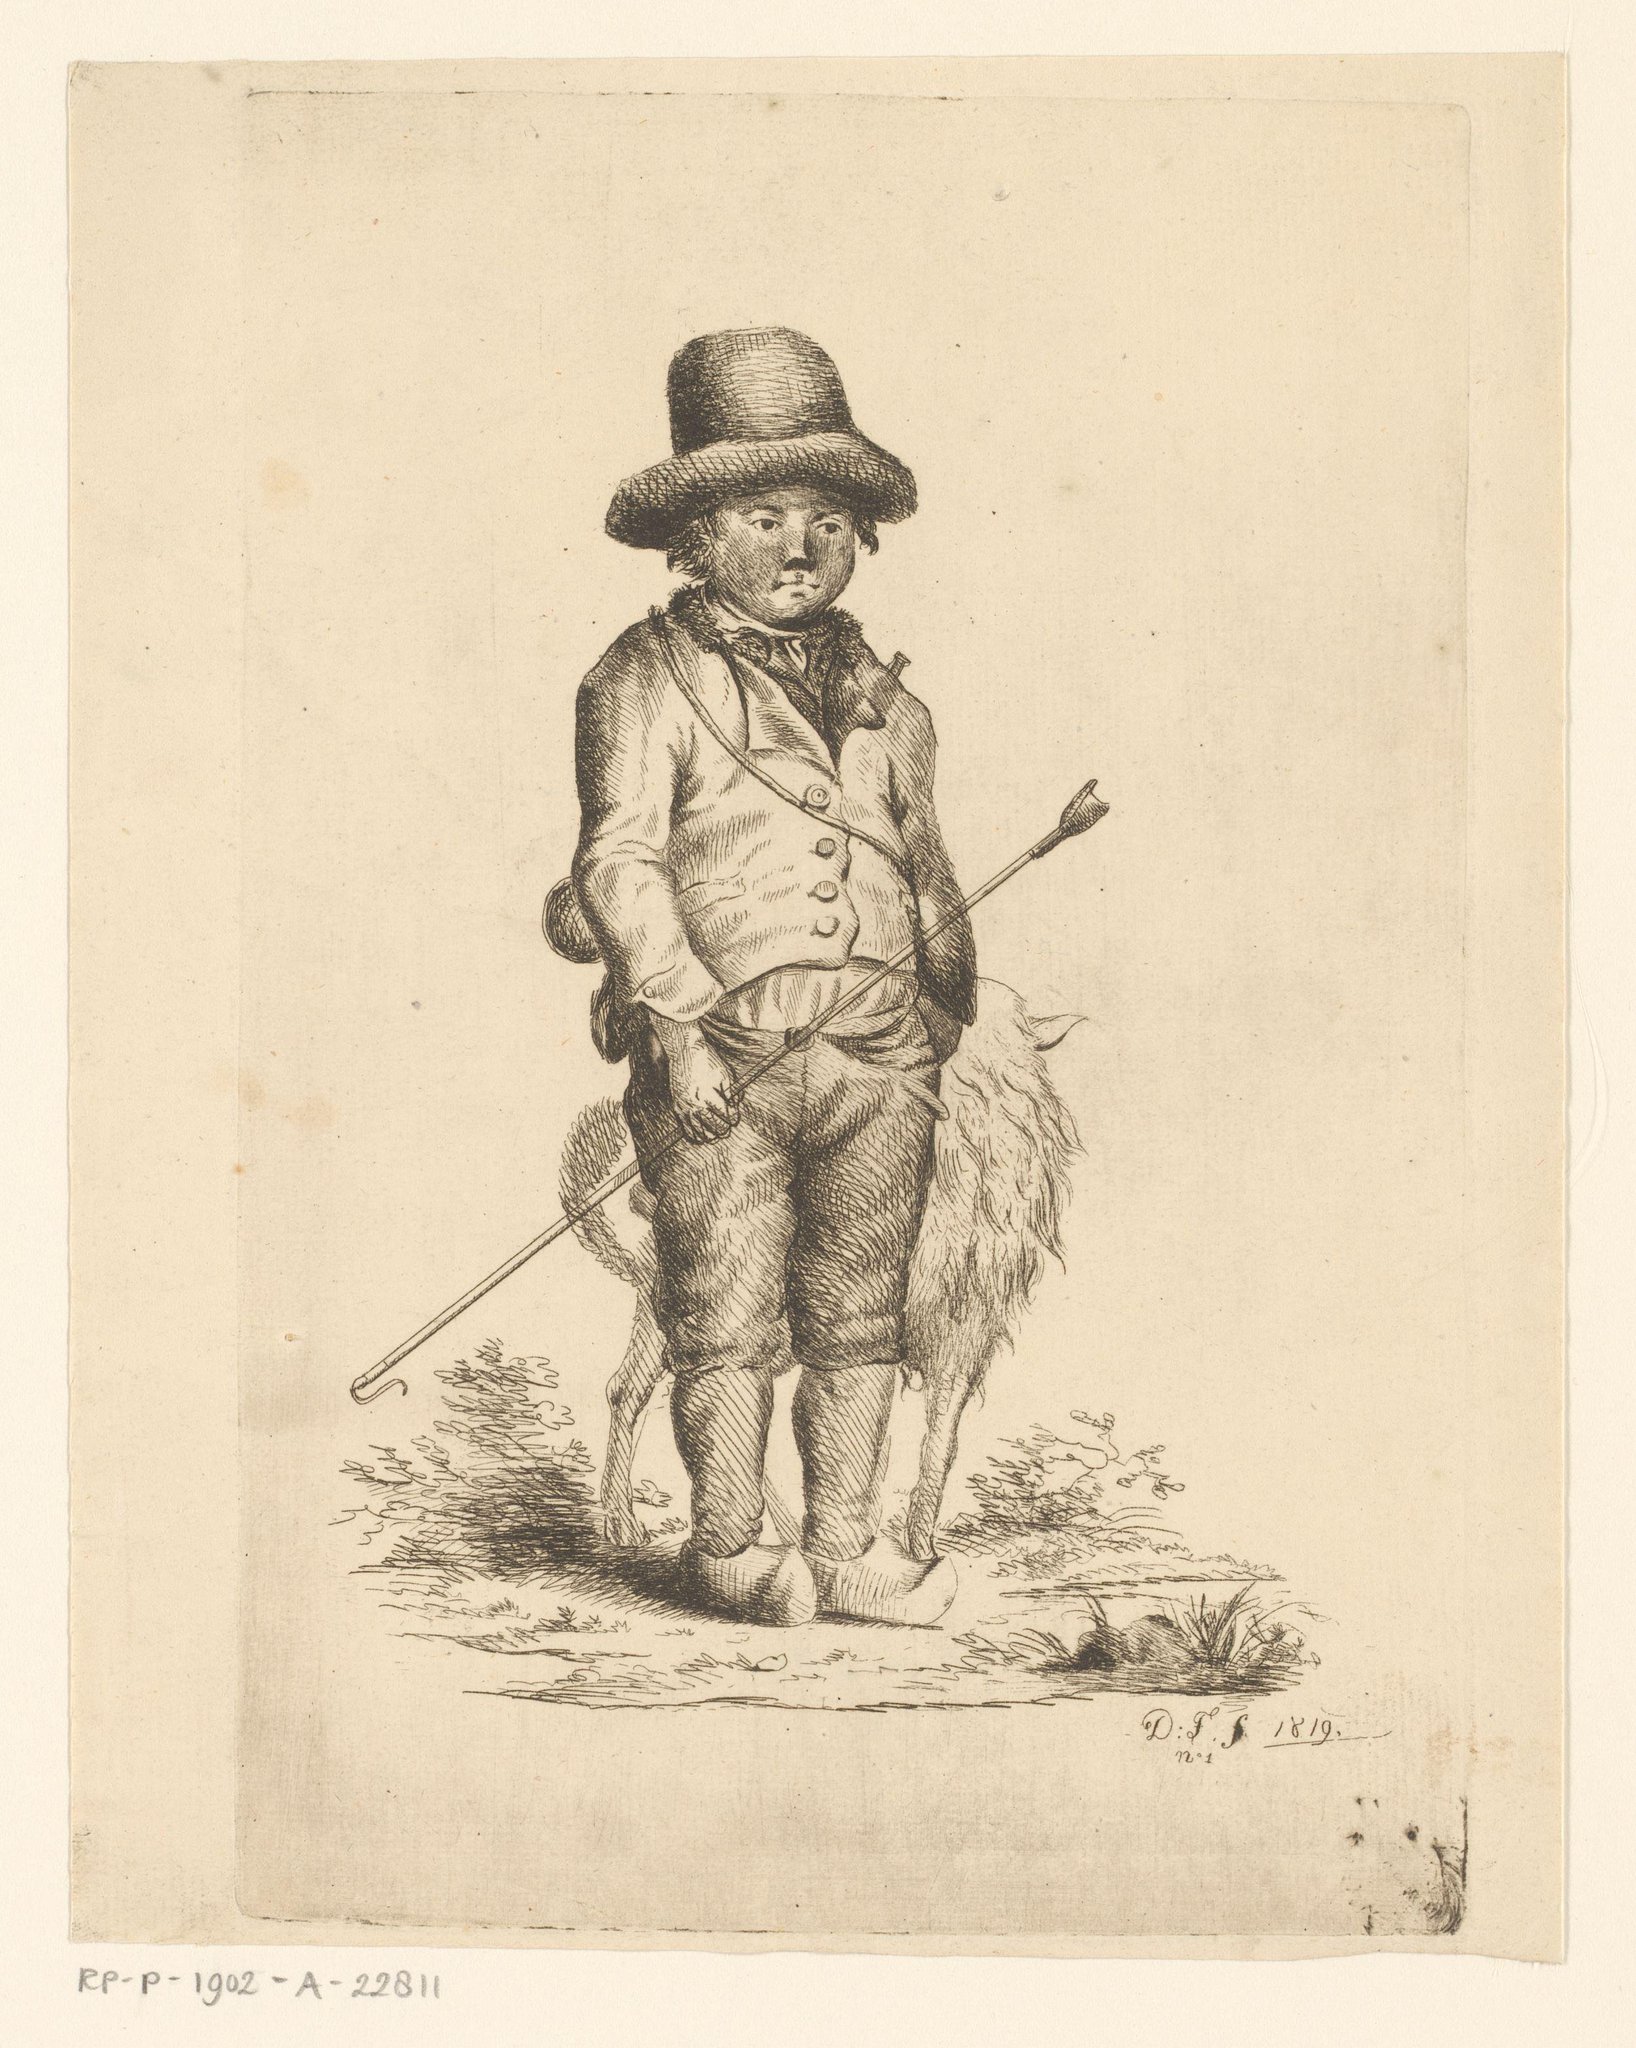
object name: print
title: Jonge herder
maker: monogrammist df (graveur)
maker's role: print maker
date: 1819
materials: paper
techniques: etching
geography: netherlands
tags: herding, herdsman, herdswoman, shepherd, shepherdess, cowherd, etc., sheep, dog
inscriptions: collector's mark: Lugt 2228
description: Een jonge herder staat met een staf in zijn handen voor een schaap of hond. De jongen draagt een hoed en klompen. Rechtsonder: no. 1.